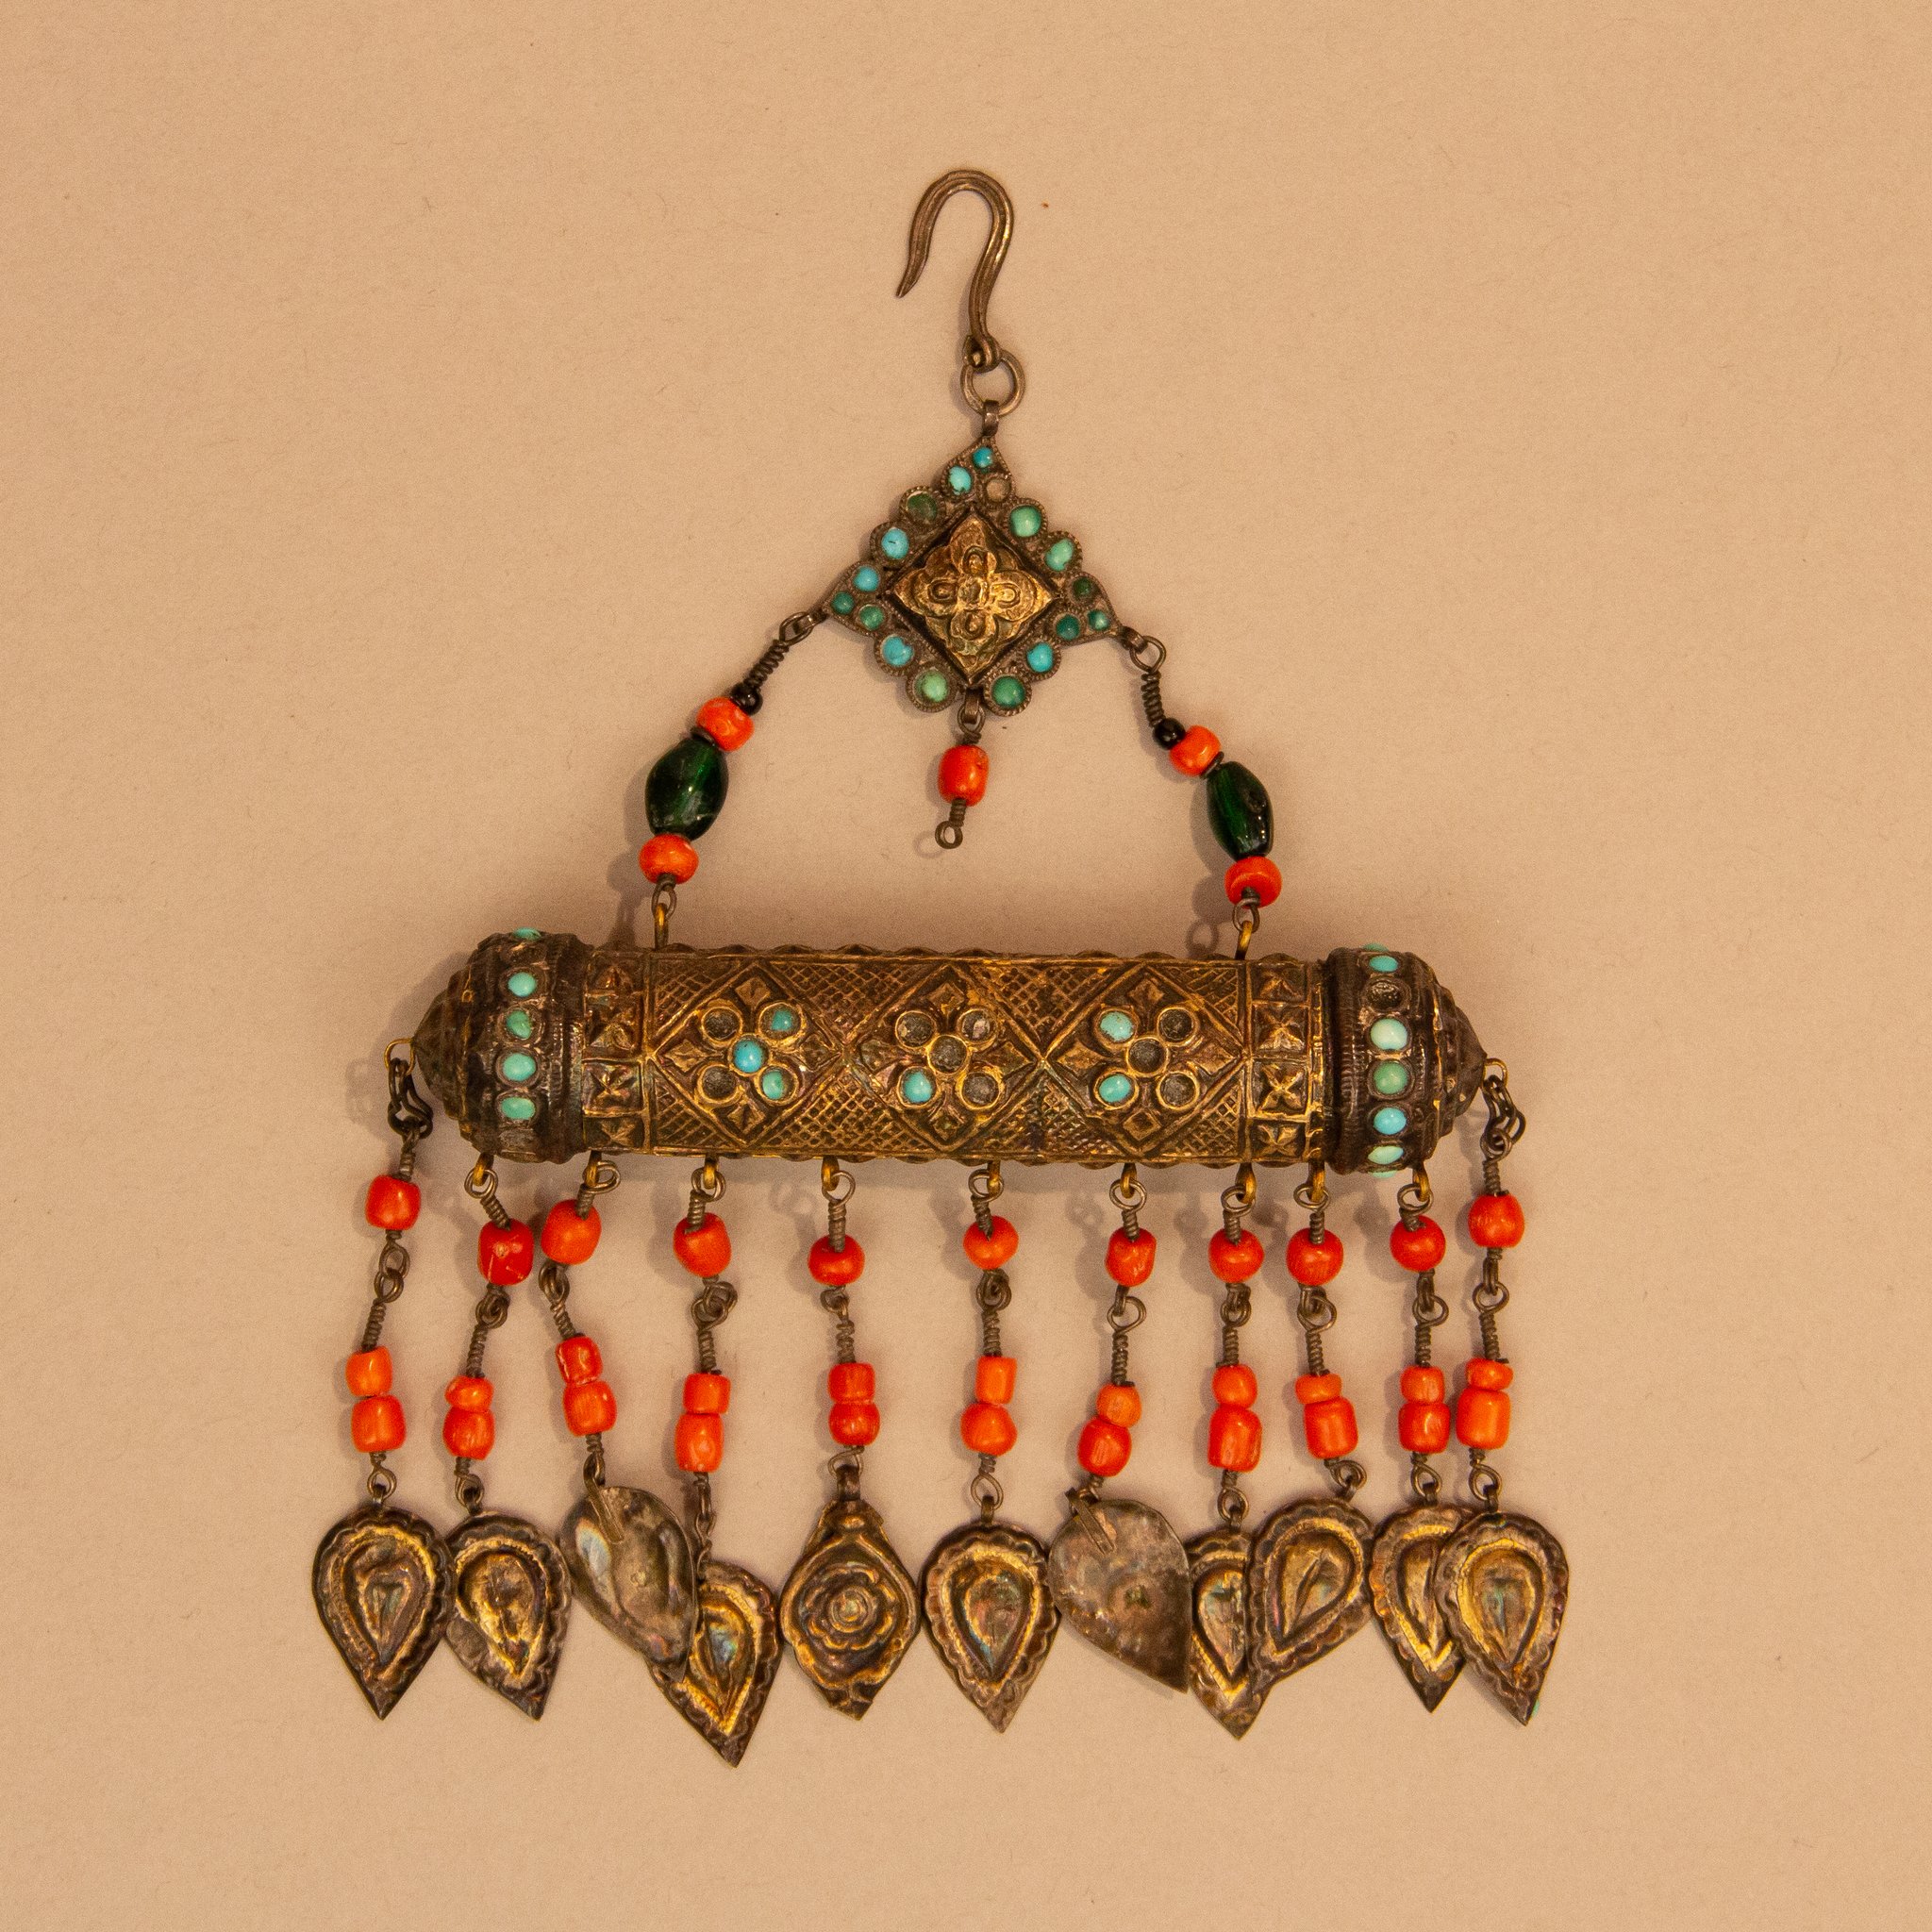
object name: amulet case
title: Amulet Case, One of a Pair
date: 1801-1900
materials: coral, glass, silver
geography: uzbekistan